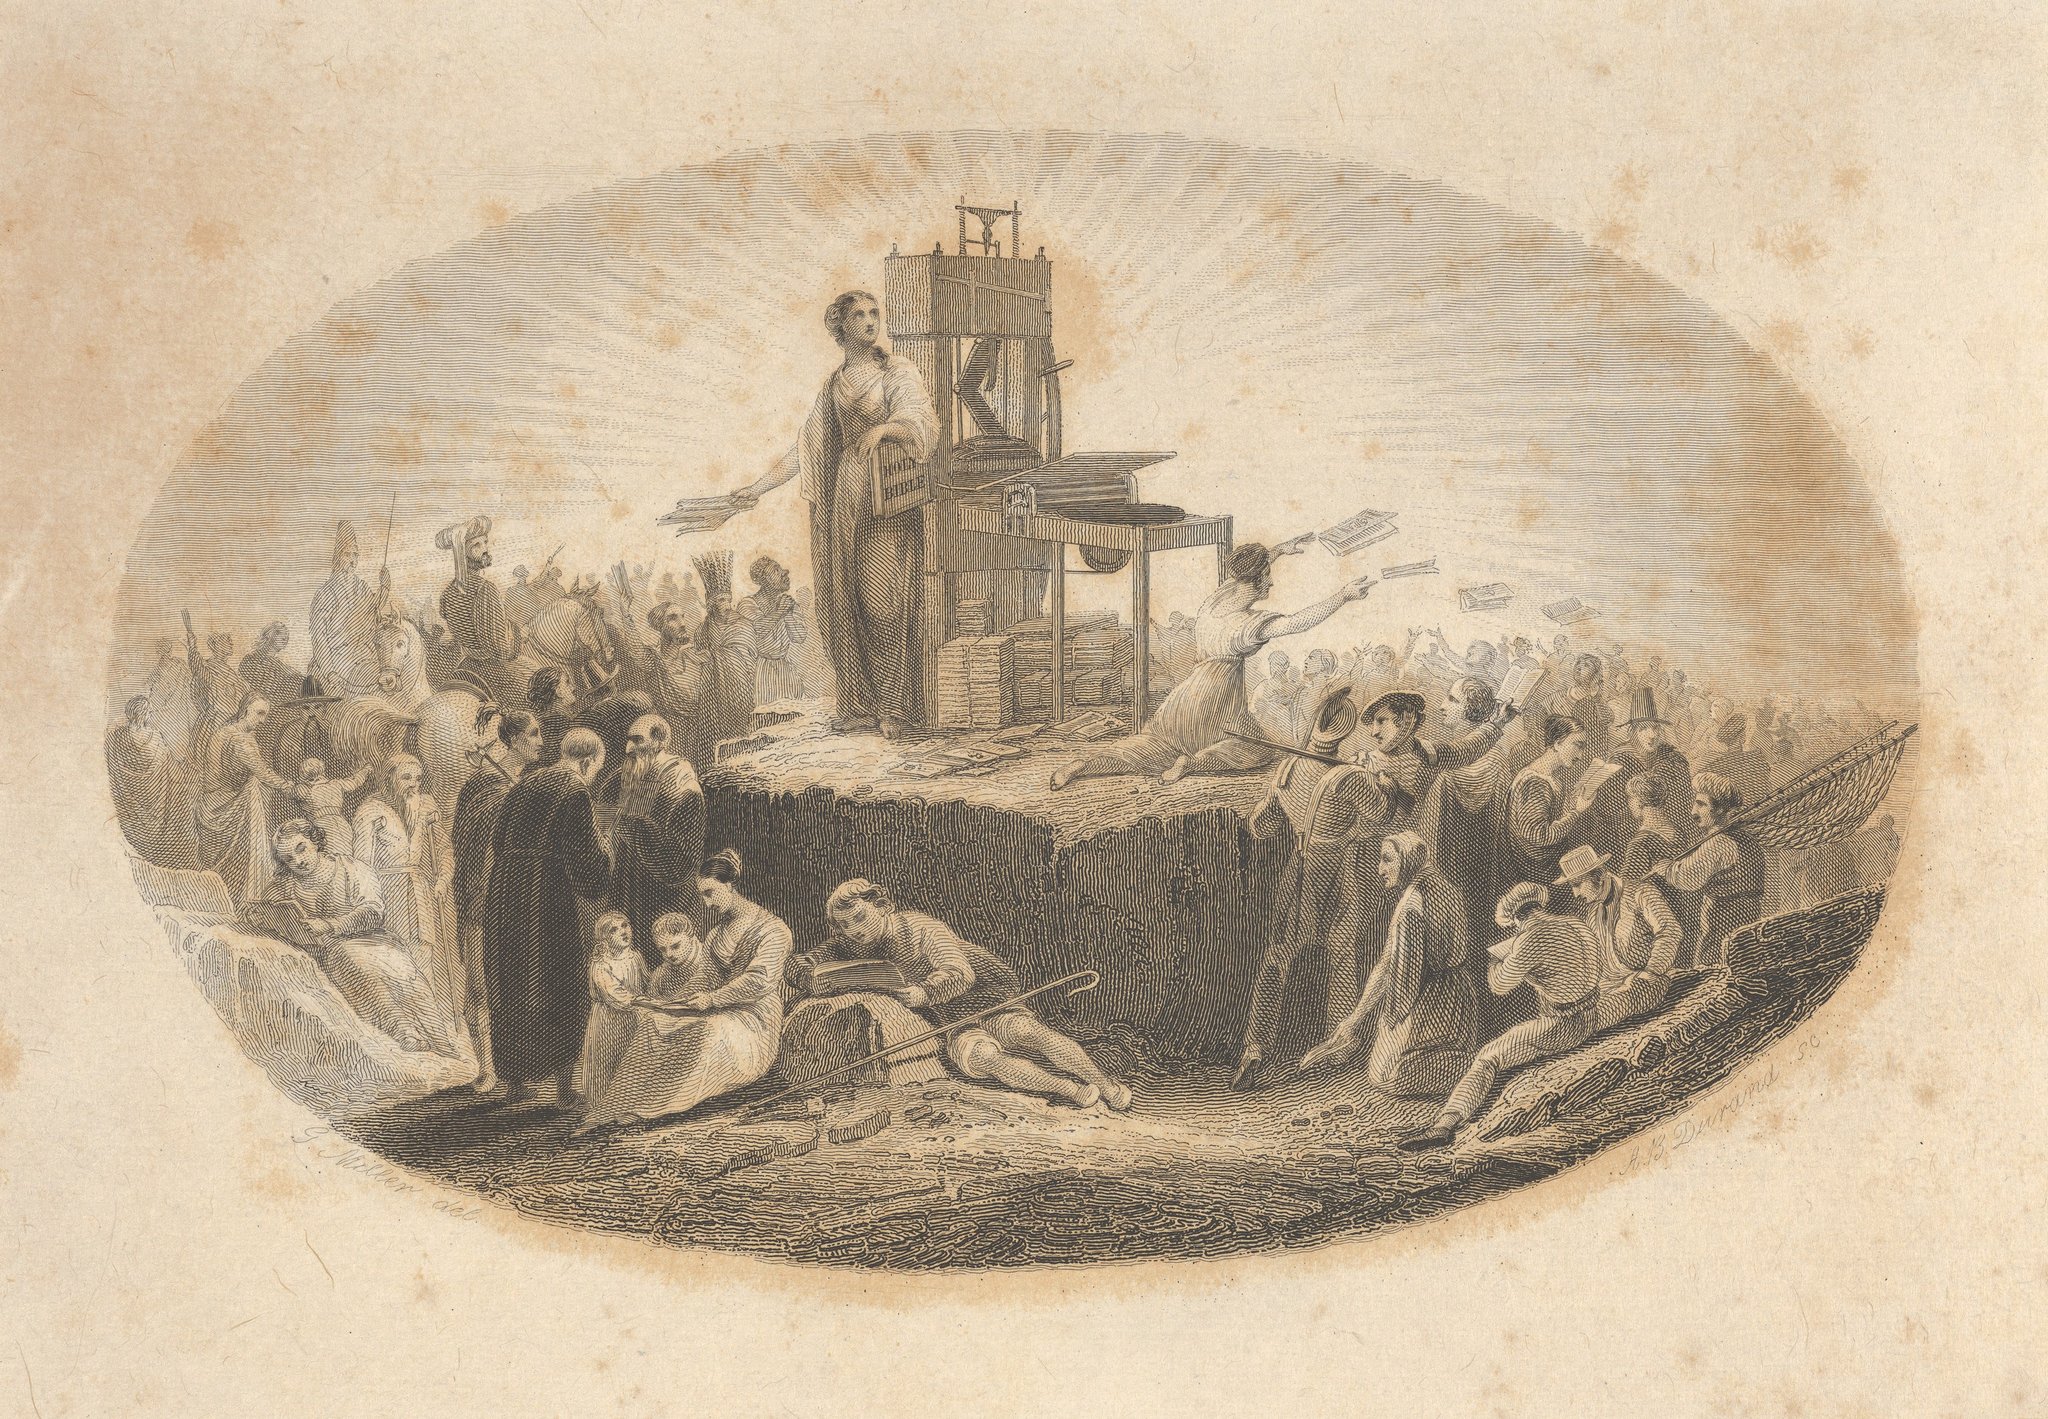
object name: print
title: Certificate of Bible Society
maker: asher brown durand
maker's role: artist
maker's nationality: american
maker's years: 1796-1886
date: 1801-1900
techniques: printmaking, engraving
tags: books,men,women,crowd,printing press